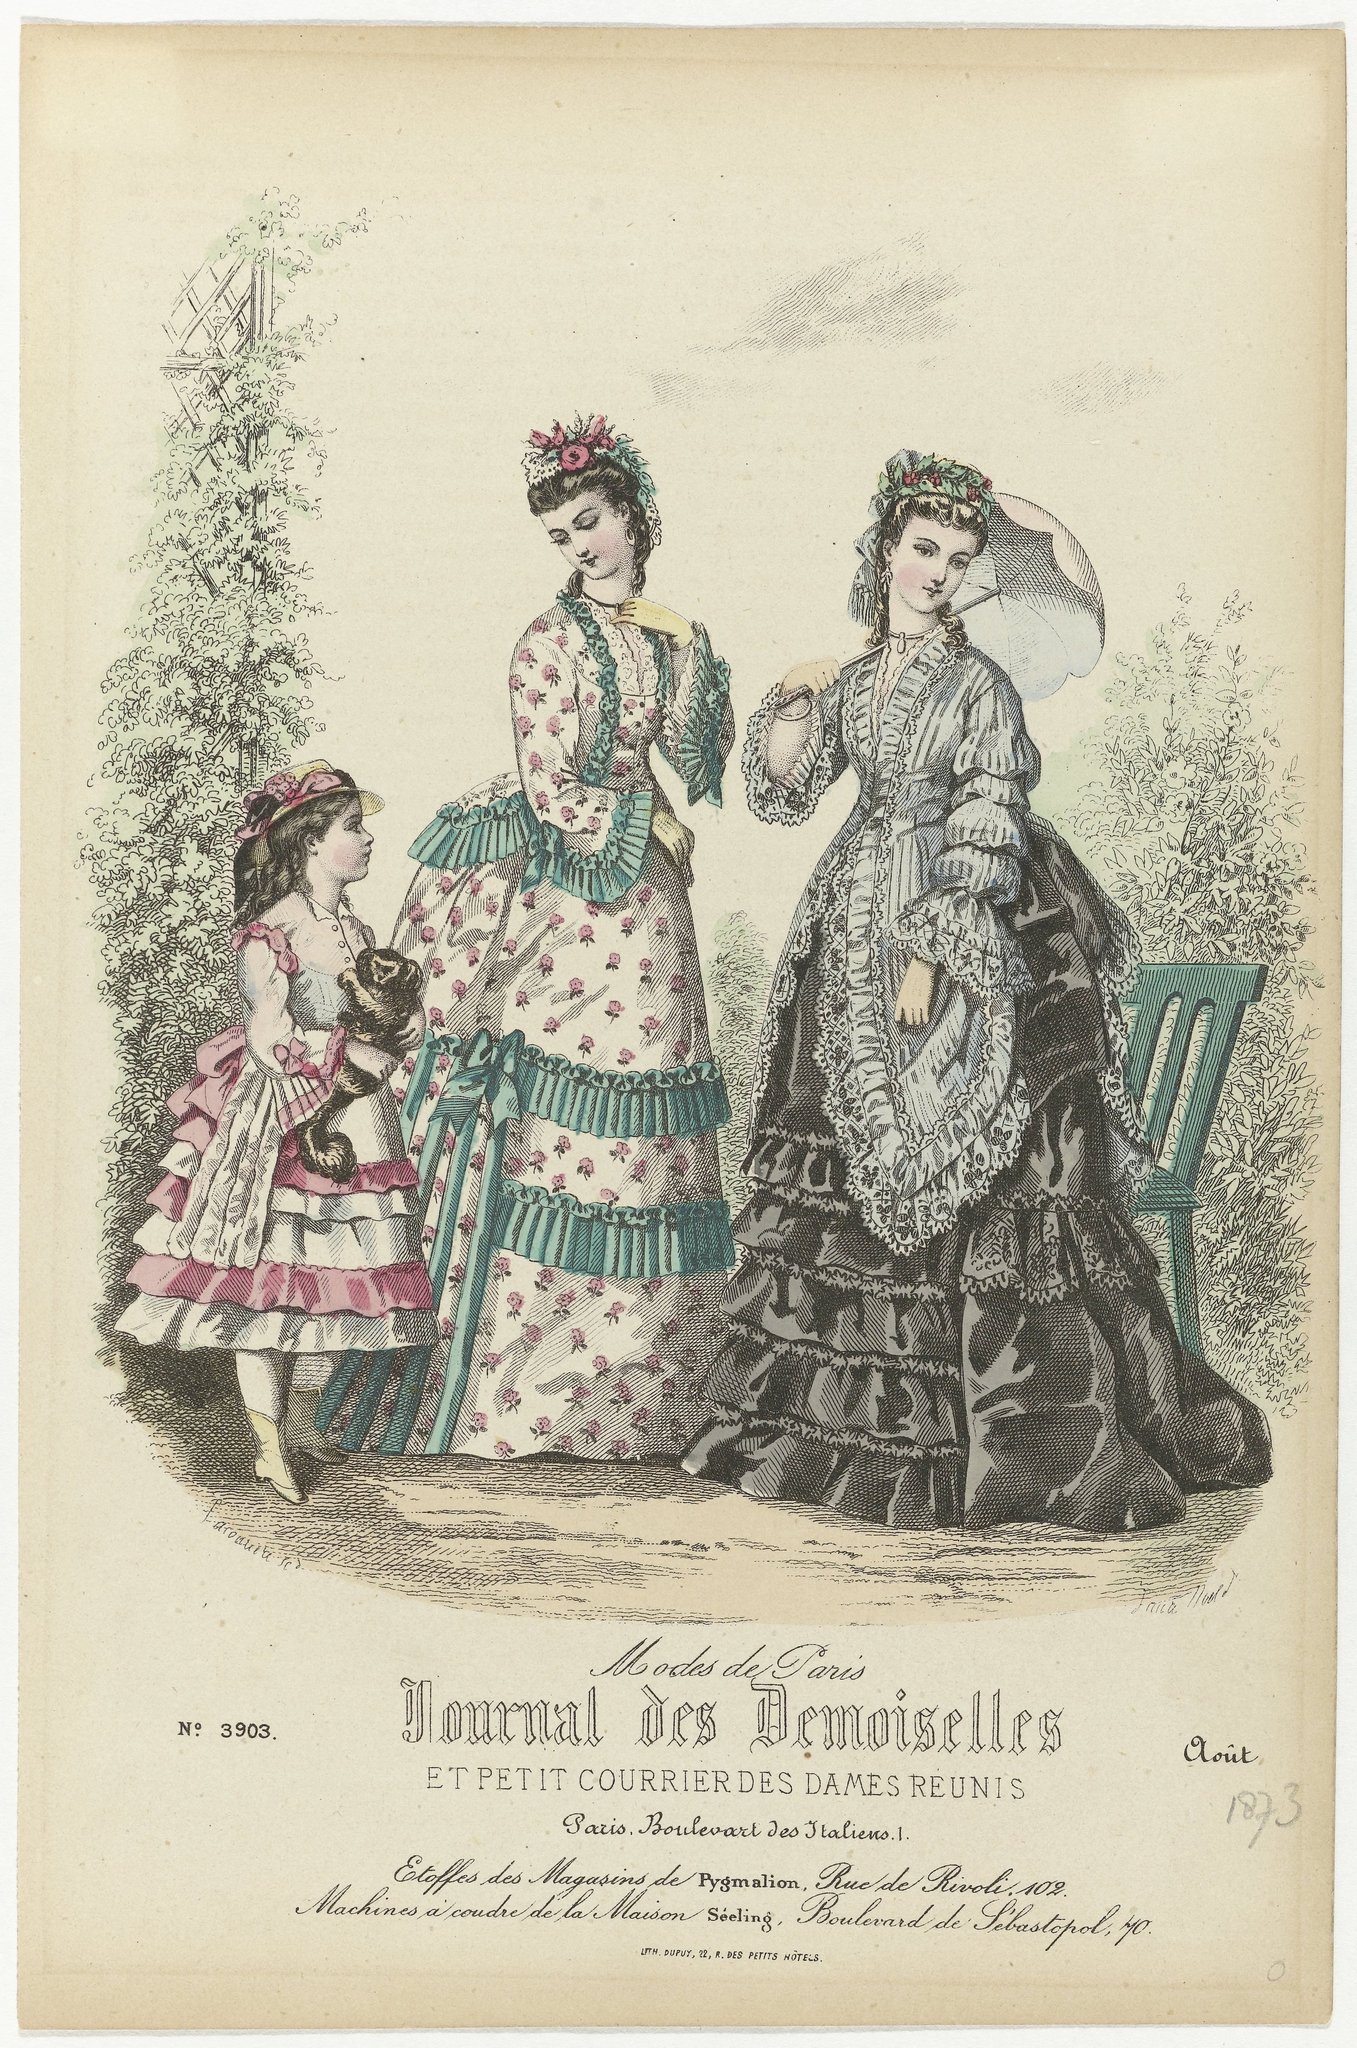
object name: fashion print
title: Journal des Demoiselles et Petit Courrier des Dames Réunis, Août 1873, No. 3903 : Etoffes des Magasins (...)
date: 1873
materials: paper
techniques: engraving, hand coloring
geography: paris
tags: bow (ornamental part of clothing) (+ women's clothes), clothing for the upper part of the body (+ women's clothes), head-gear (+ girls' clothes), boots (+ girls' clothes), head-gear (+ women's clothes), fashion plates, skirt (+ women's clothes), gloves, mittens, etc. (+ women's clothes), domestic animals, kept in and outside the house, sleeves (+ women's clothes), necklace (+ women's clothes), parasol, sunshade (+ women's clothes), dress, gown (+ girls' clothes)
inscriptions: address: ‘Paris, Boulevart des Italiens,1.’, caption: ‘Etoffes des Magasins de Pygmalion, Rue de Rivoli, 102. Machines à coudre de la Maison Séeling, Boulevard de Sébastopol, 70.’, title: ‘Modes de Paris / Journal des Demoiselles / et Petit Courrier des Dames reunis’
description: Twee vrouwen en een meisje buiten, gekleed in wandelkostuums. Onder de voorstelling volgen enkele regels reclametekst voor verschillende producten. Prent uit het modetijdschrift Journal des Demoiselles (et Petit Courrier des Dames Réunis) (1833-1922).